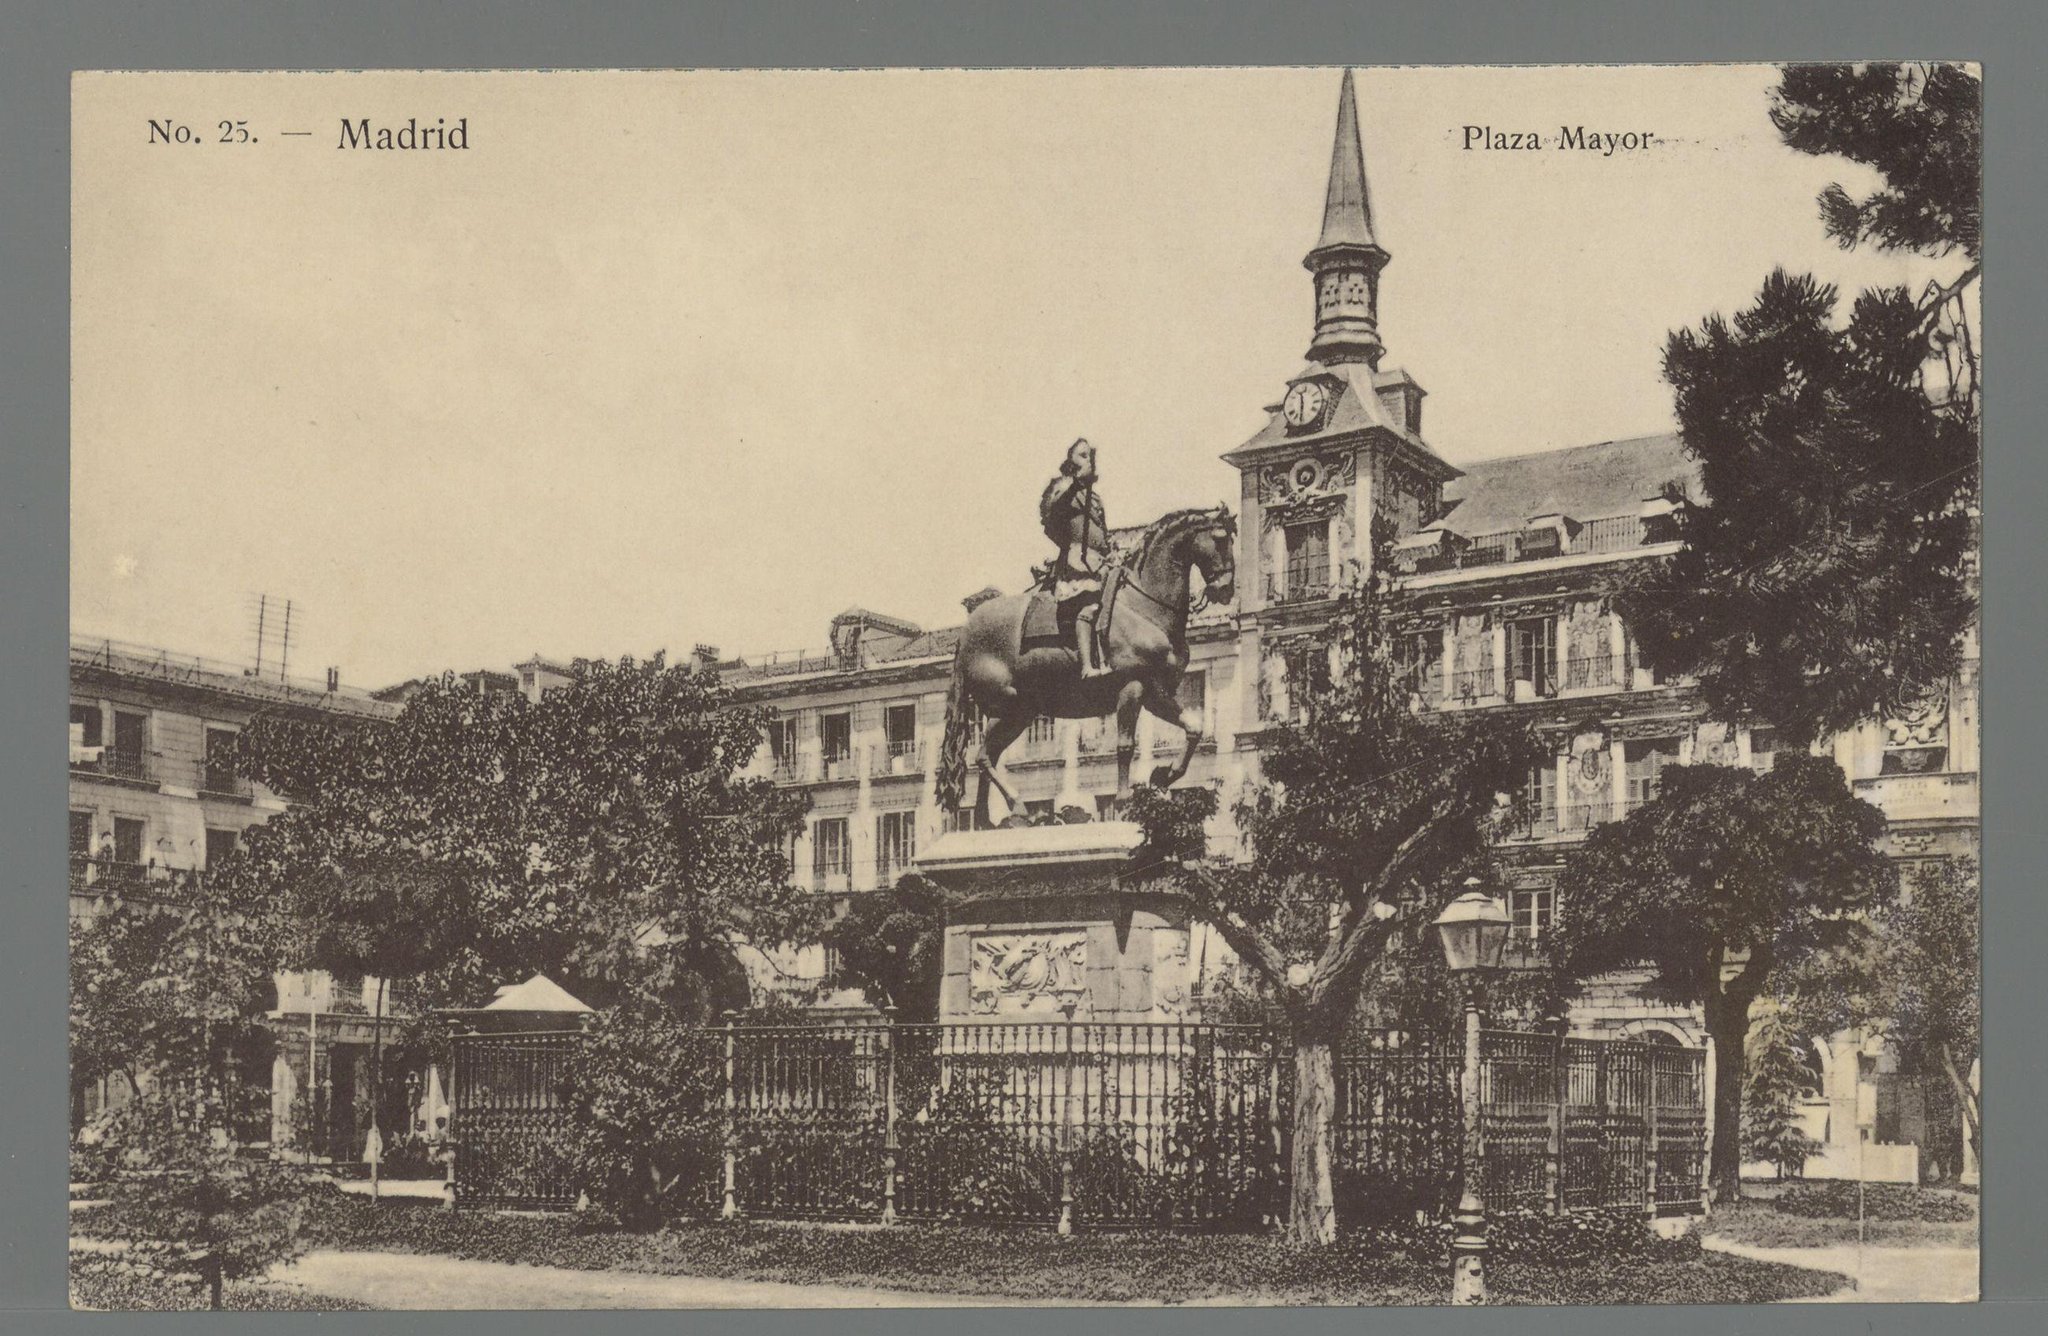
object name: ansichtkaart, prentbriefkaart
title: Madrid. Plaza Mayor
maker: Anonymous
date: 1906-1930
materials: cardboard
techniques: photograph, writing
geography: madrid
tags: square, place, circus, etc., monument, statue